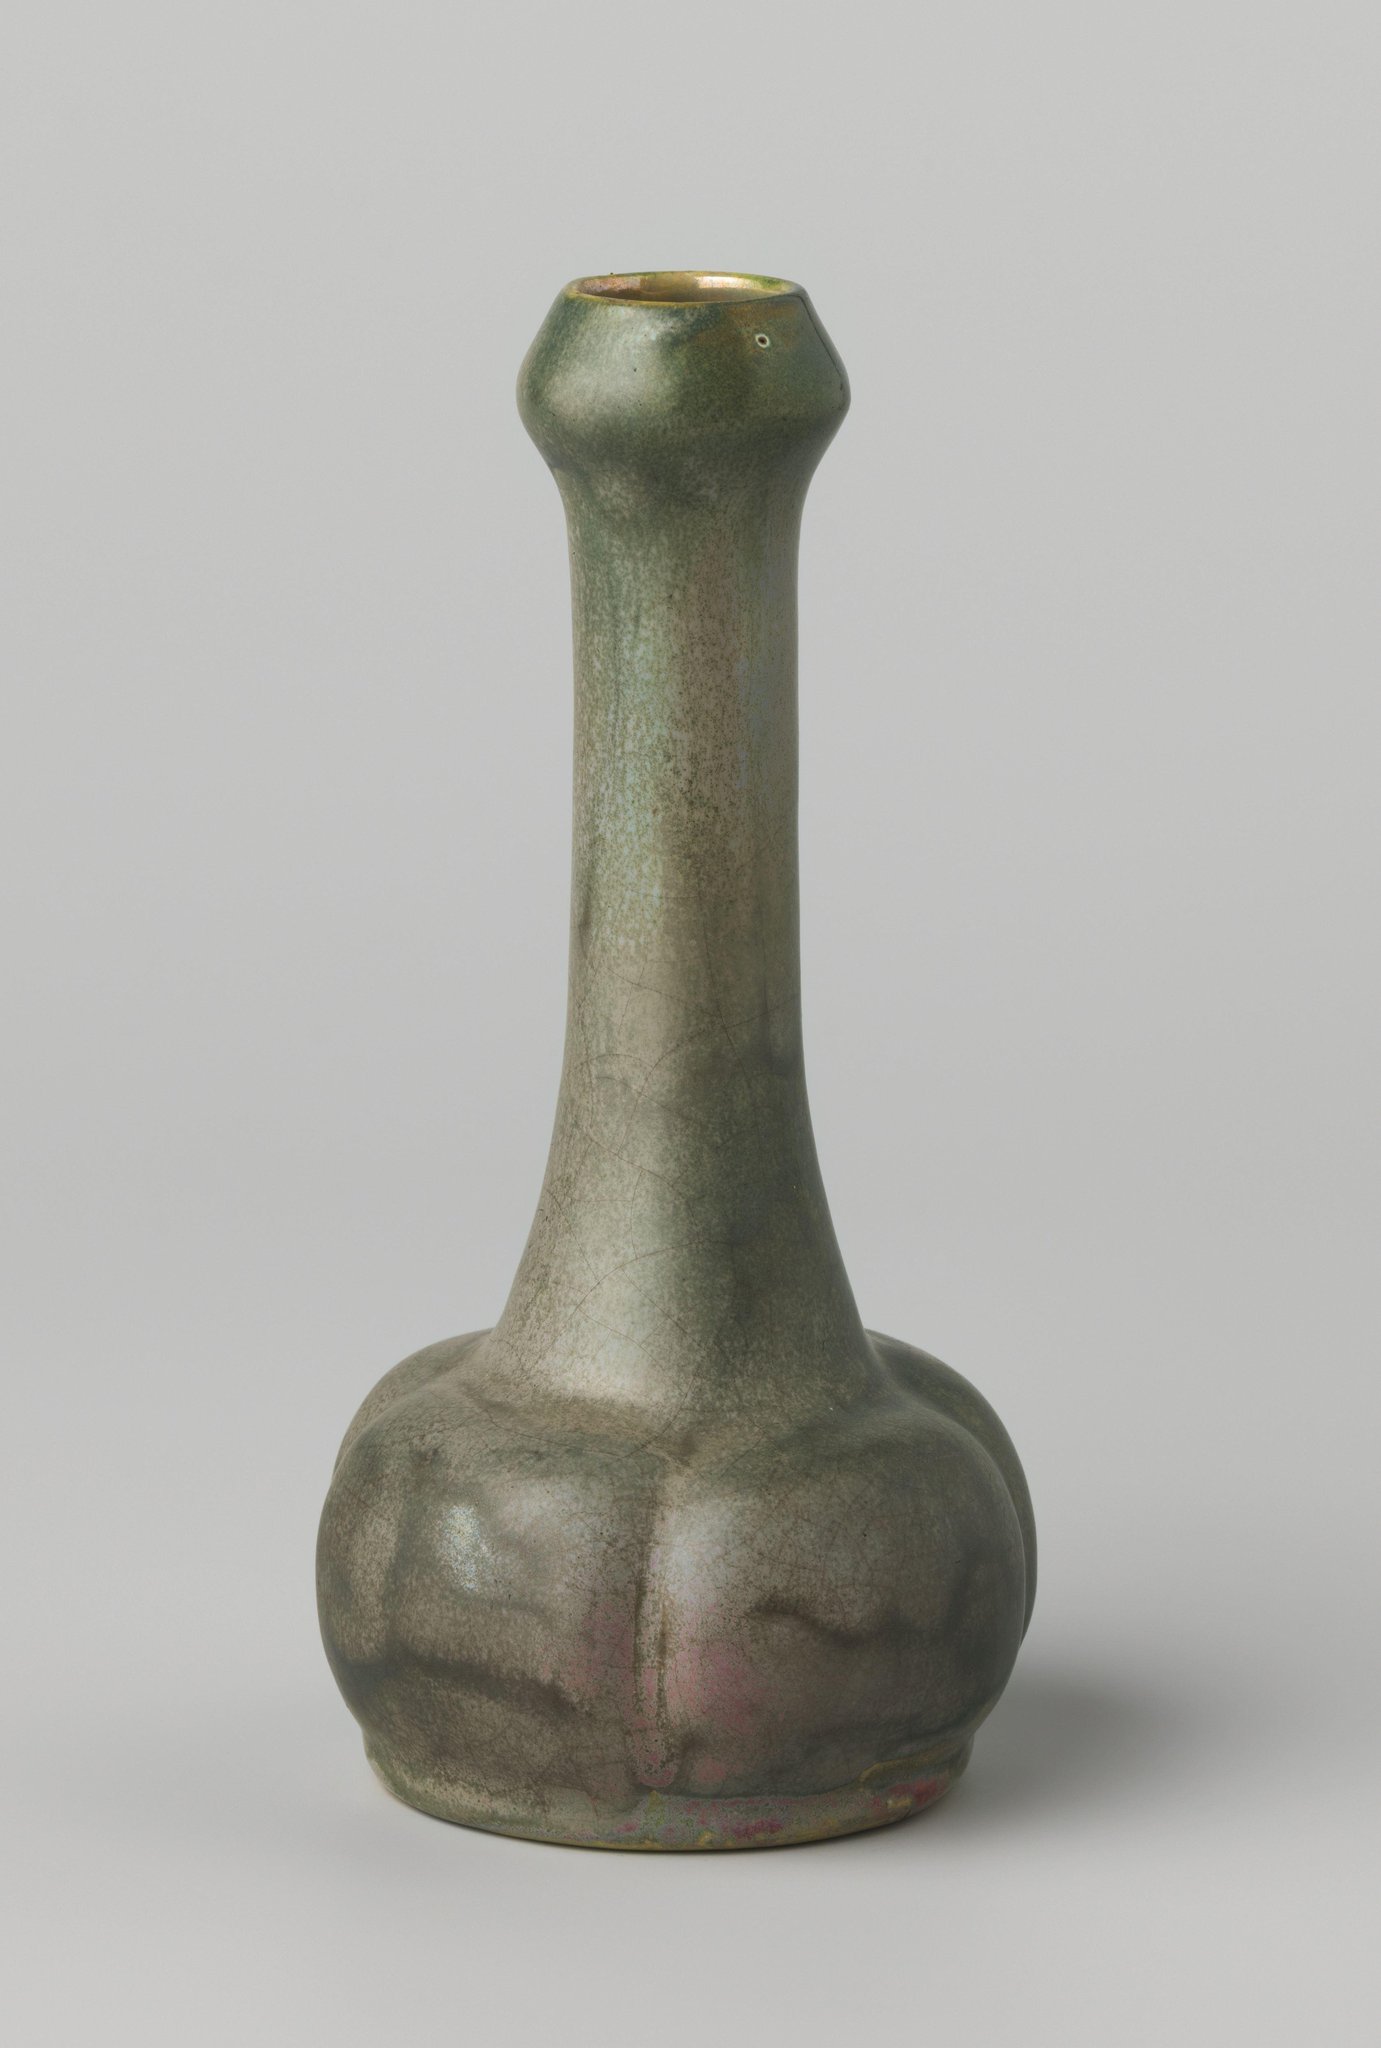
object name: vase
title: Vase with a Green Glaze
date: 1898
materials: earthenware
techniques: vitrification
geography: delft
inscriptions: mark: ‘fles // Delft // monogram. T. // Boz. // v’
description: Vaas van aardewerk, met slanke hals en vierlobbig lichaam, bedekt met groene glazuur. De hals heeft bovenaan een verdikking.